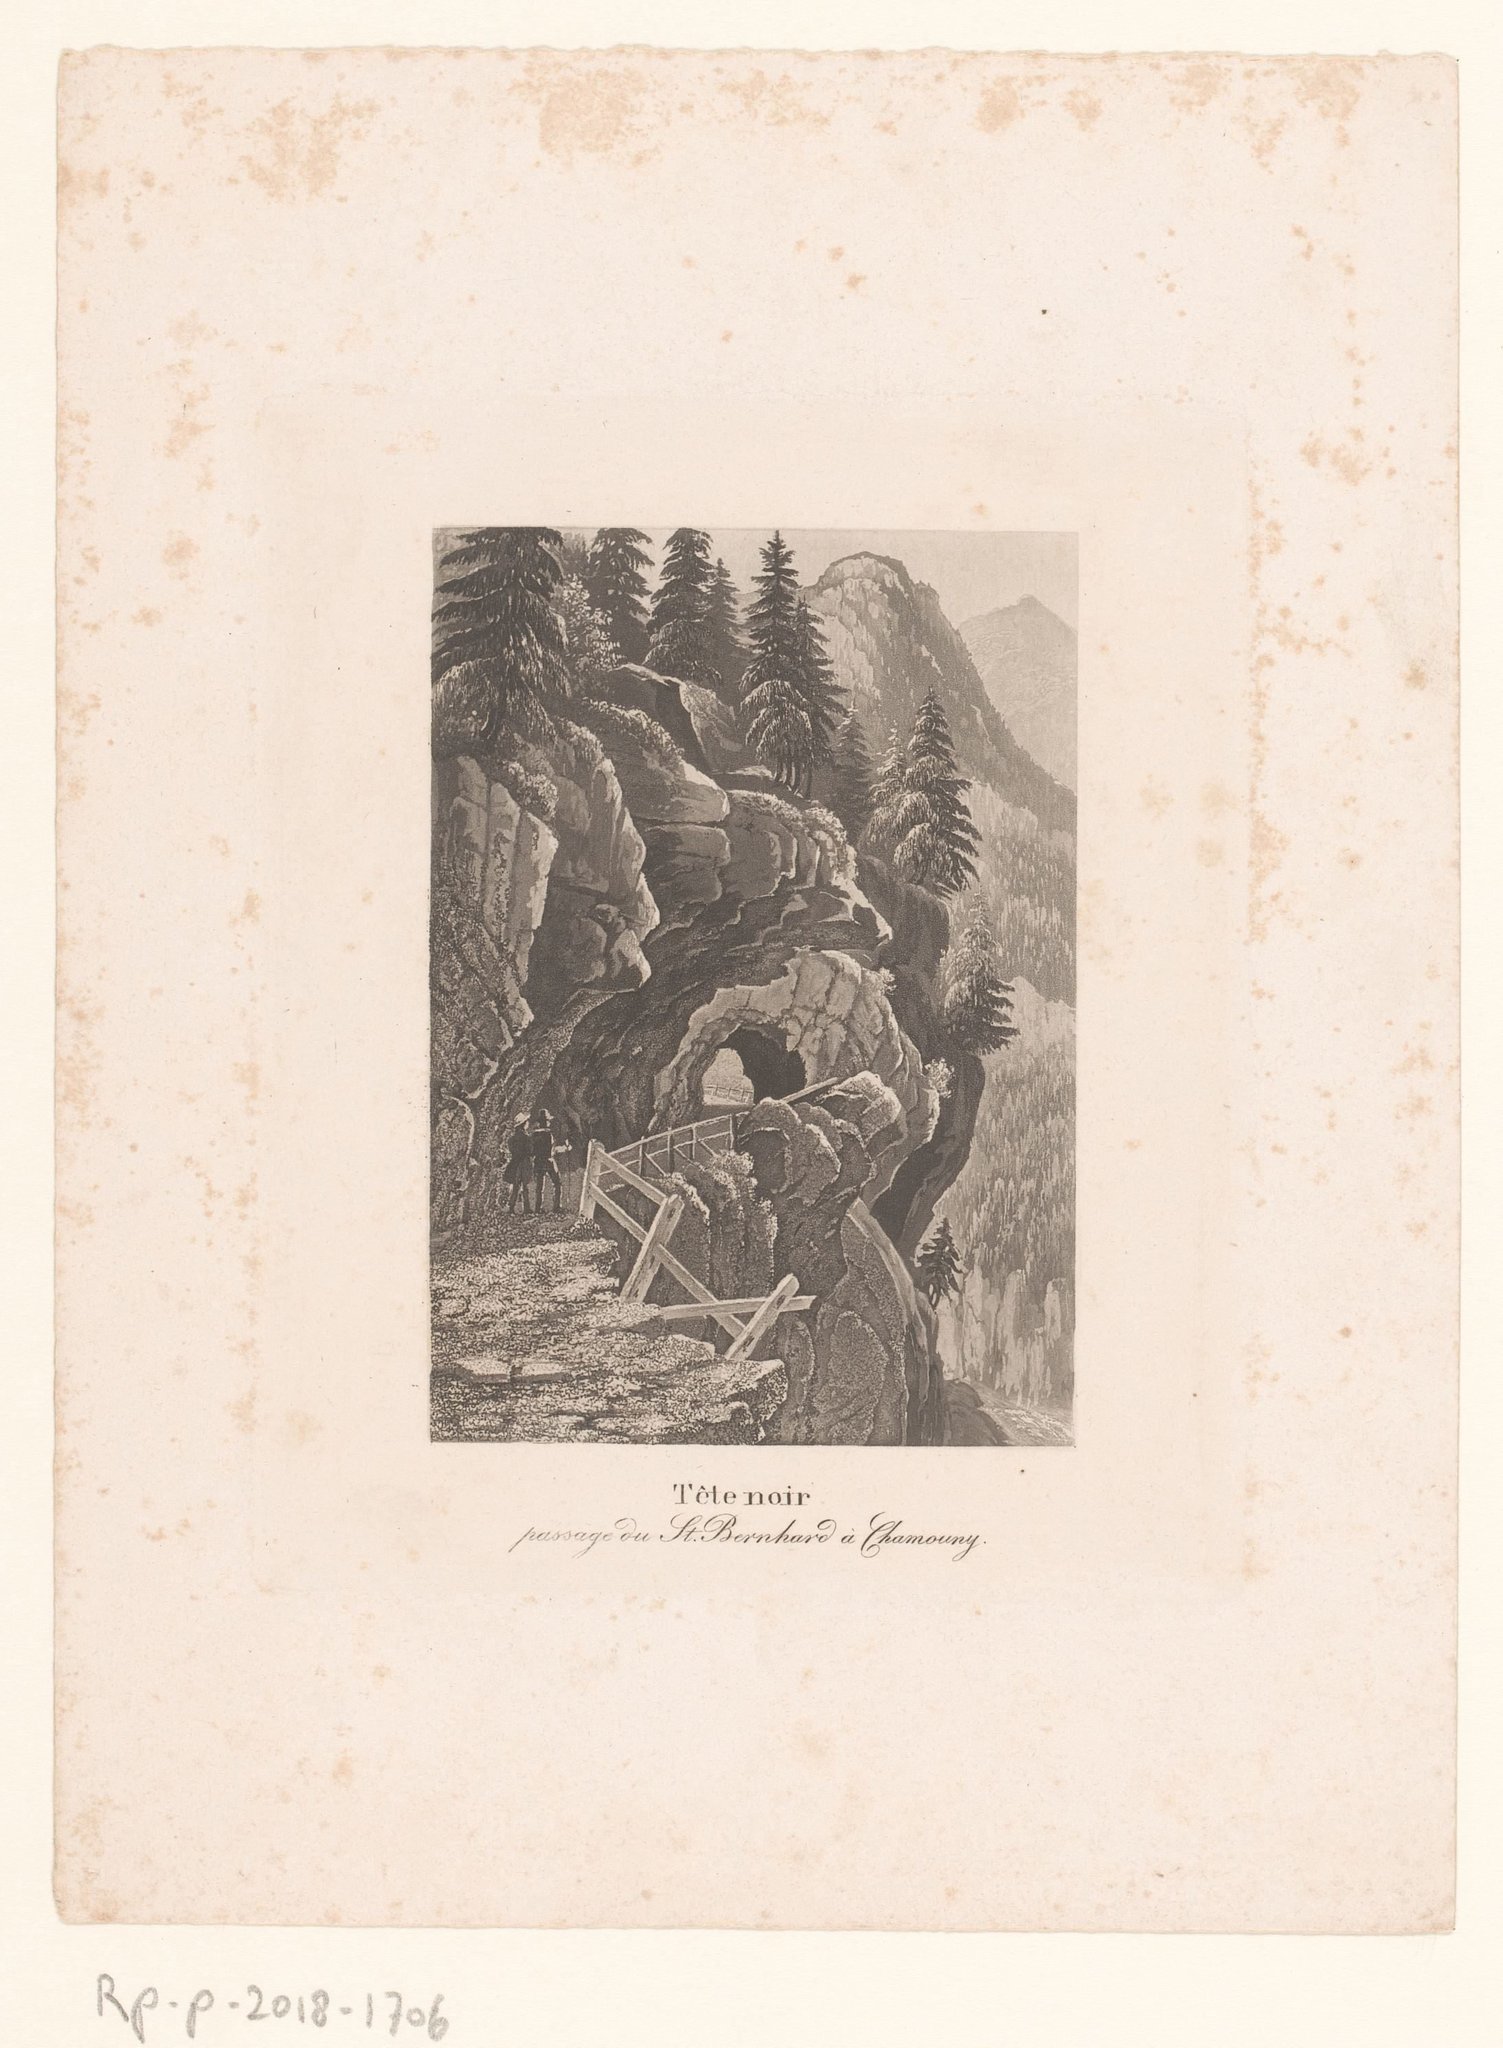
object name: print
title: Tête noir passage du St. Bernhard à Chamouny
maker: Anonymous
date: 1800-1899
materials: paper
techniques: aquatint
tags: road, path, mountains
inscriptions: collector's mark: Lugt 2228